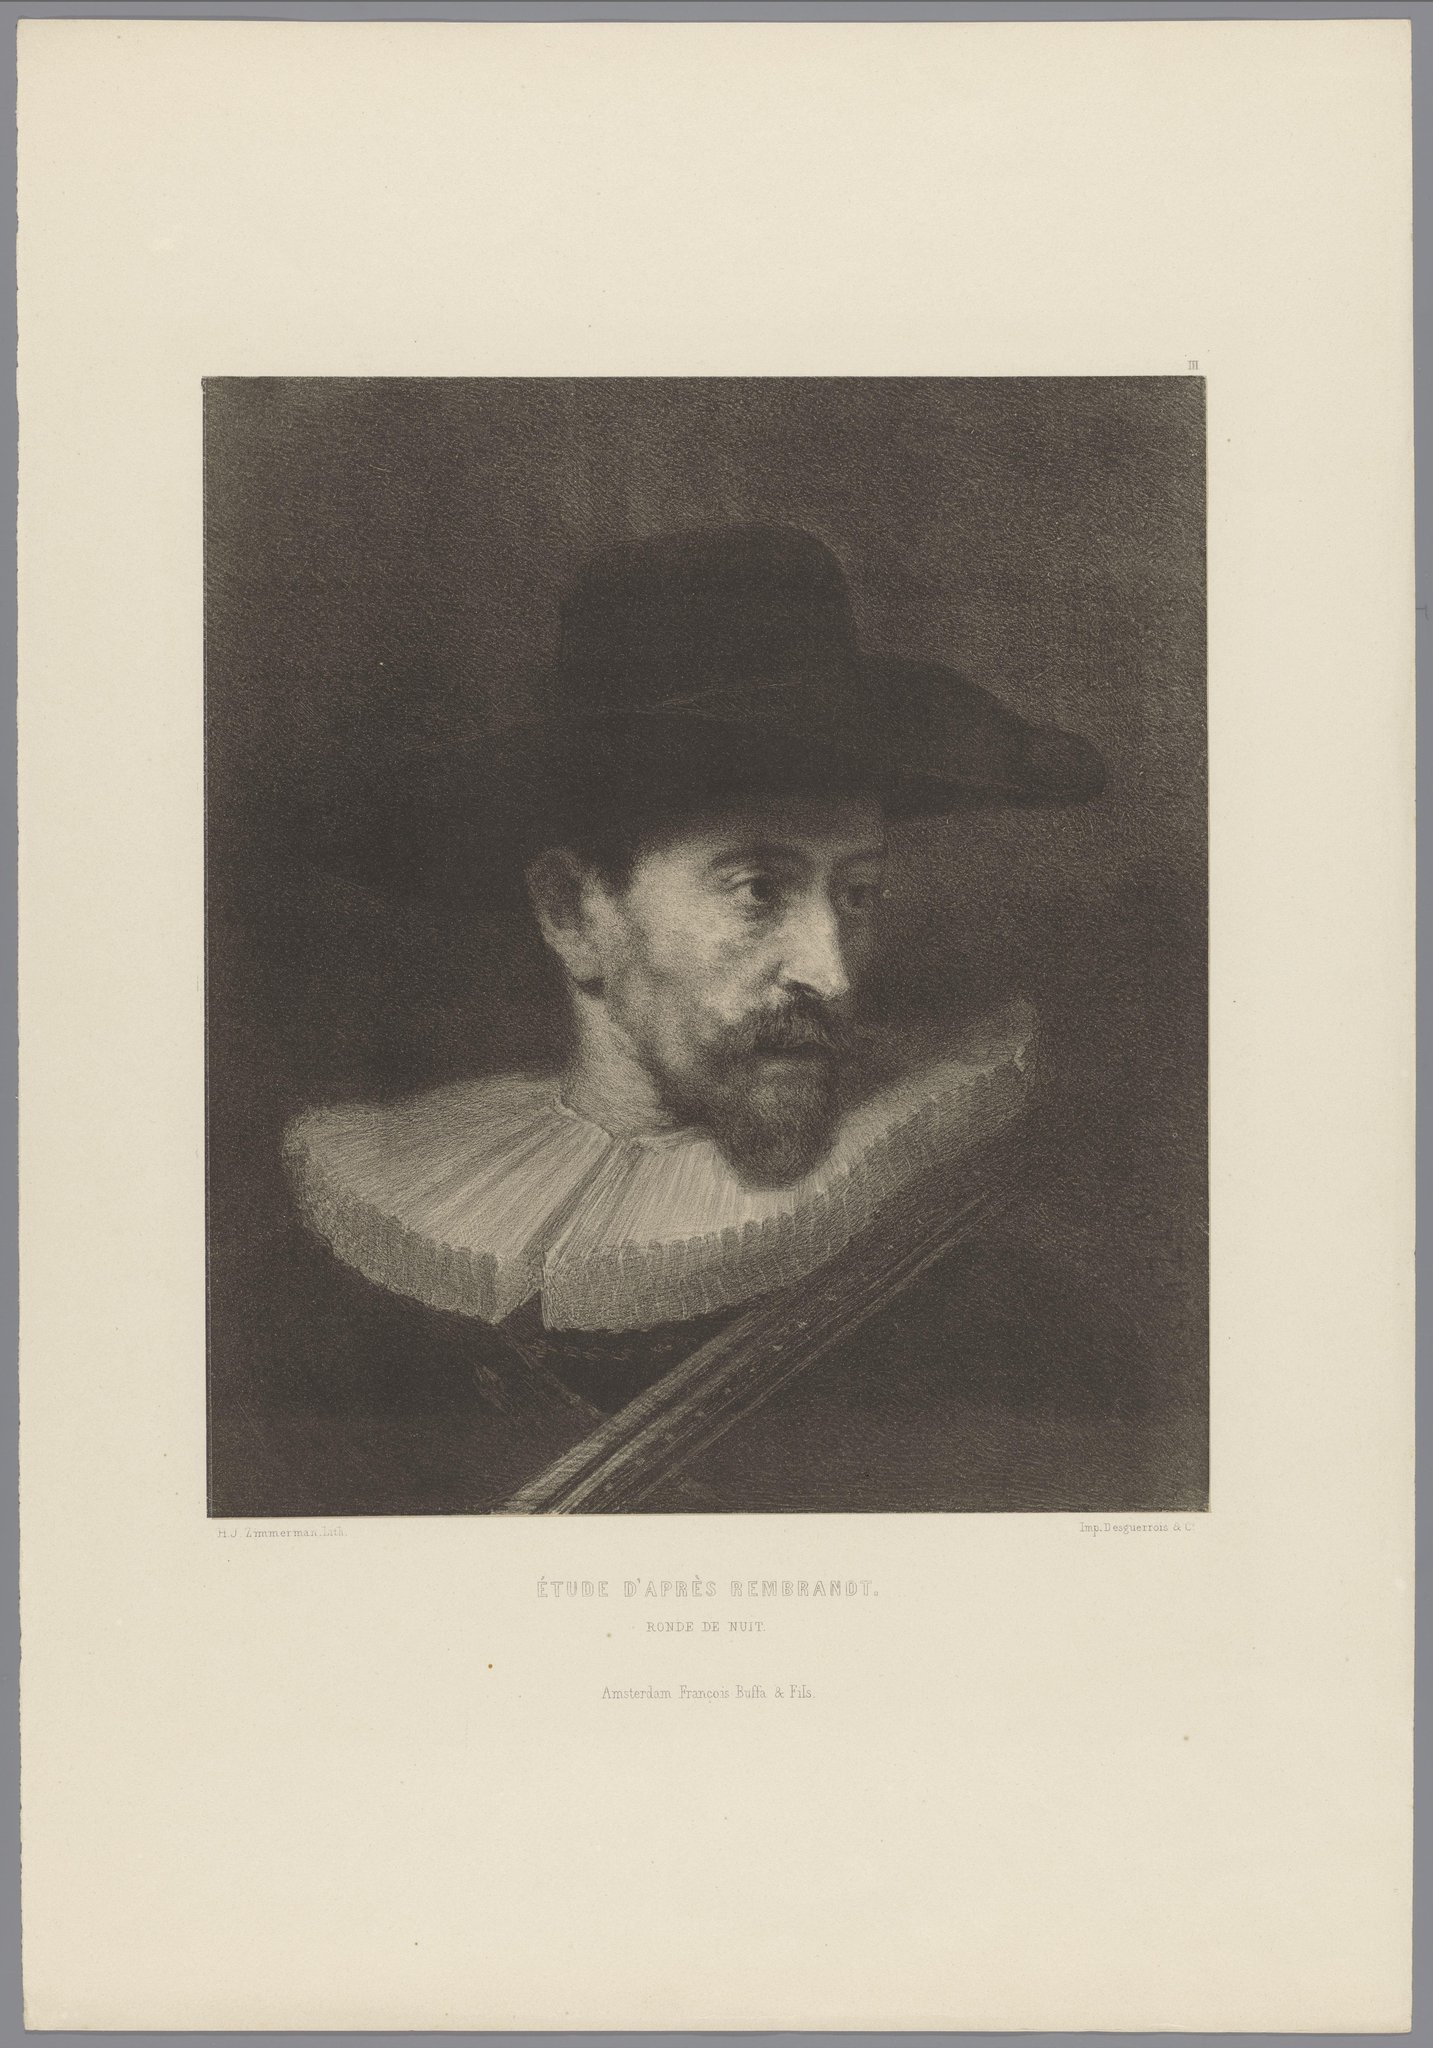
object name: print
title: Portret van sergeant Rombout Kemp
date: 1859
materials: paper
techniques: lithograph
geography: amsterdam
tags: leiden, amsterdam, print maker, draughtsman, rembrandt van rijn, picture, painting, historical persons (+ (full) bust portrait)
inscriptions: collector's mark: Lugt 2165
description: Detail uit Het korporaalschap van kapitein Frans Banning Cocq door Rembrandt. Deze prent maakt deel uit van een omslag met zeven prenten.